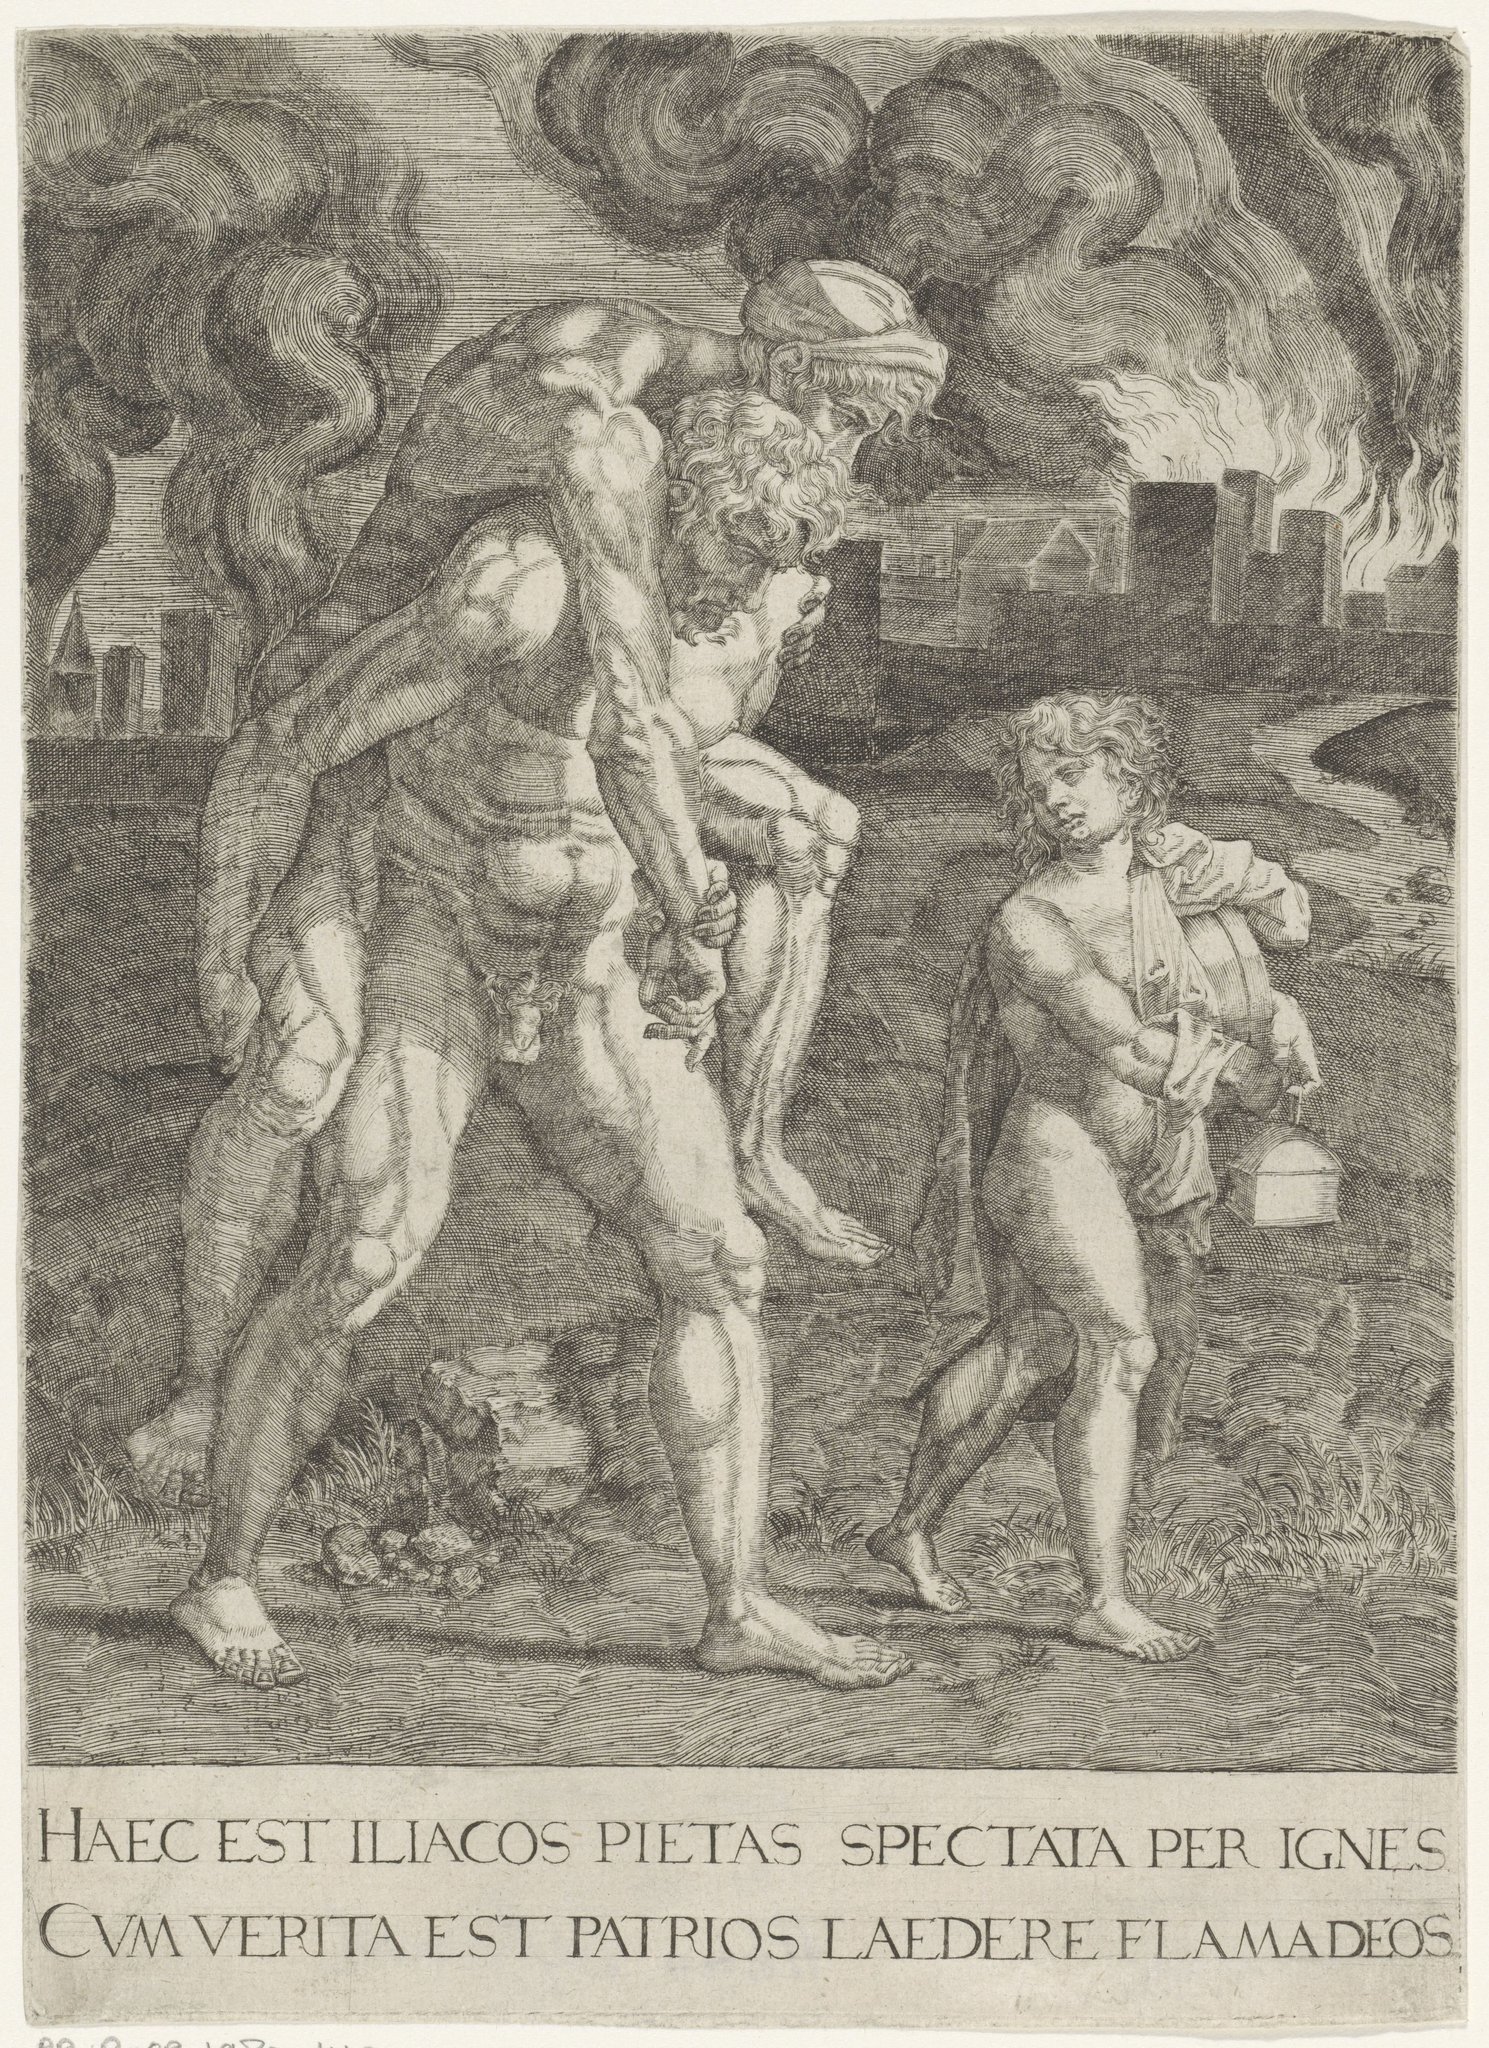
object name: print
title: Aeneas vlucht met zijn familie uit Troje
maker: Anonymous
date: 1515-1565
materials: paper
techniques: engraving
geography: italy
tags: 'pius aeneas': aeneas, leading ascanius, escapes from burning troy, carrying his father anchises with the penates; his wife creusa, who sets out with them, is lost on the way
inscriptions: collector's mark: Lugt 2760, collector's mark: Lugt 2228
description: Aeneas ontvlucht het brandende Troje met zijn vader Anchises op de rug. Rechts loopt Ascanius, de zoon van Aeneas.